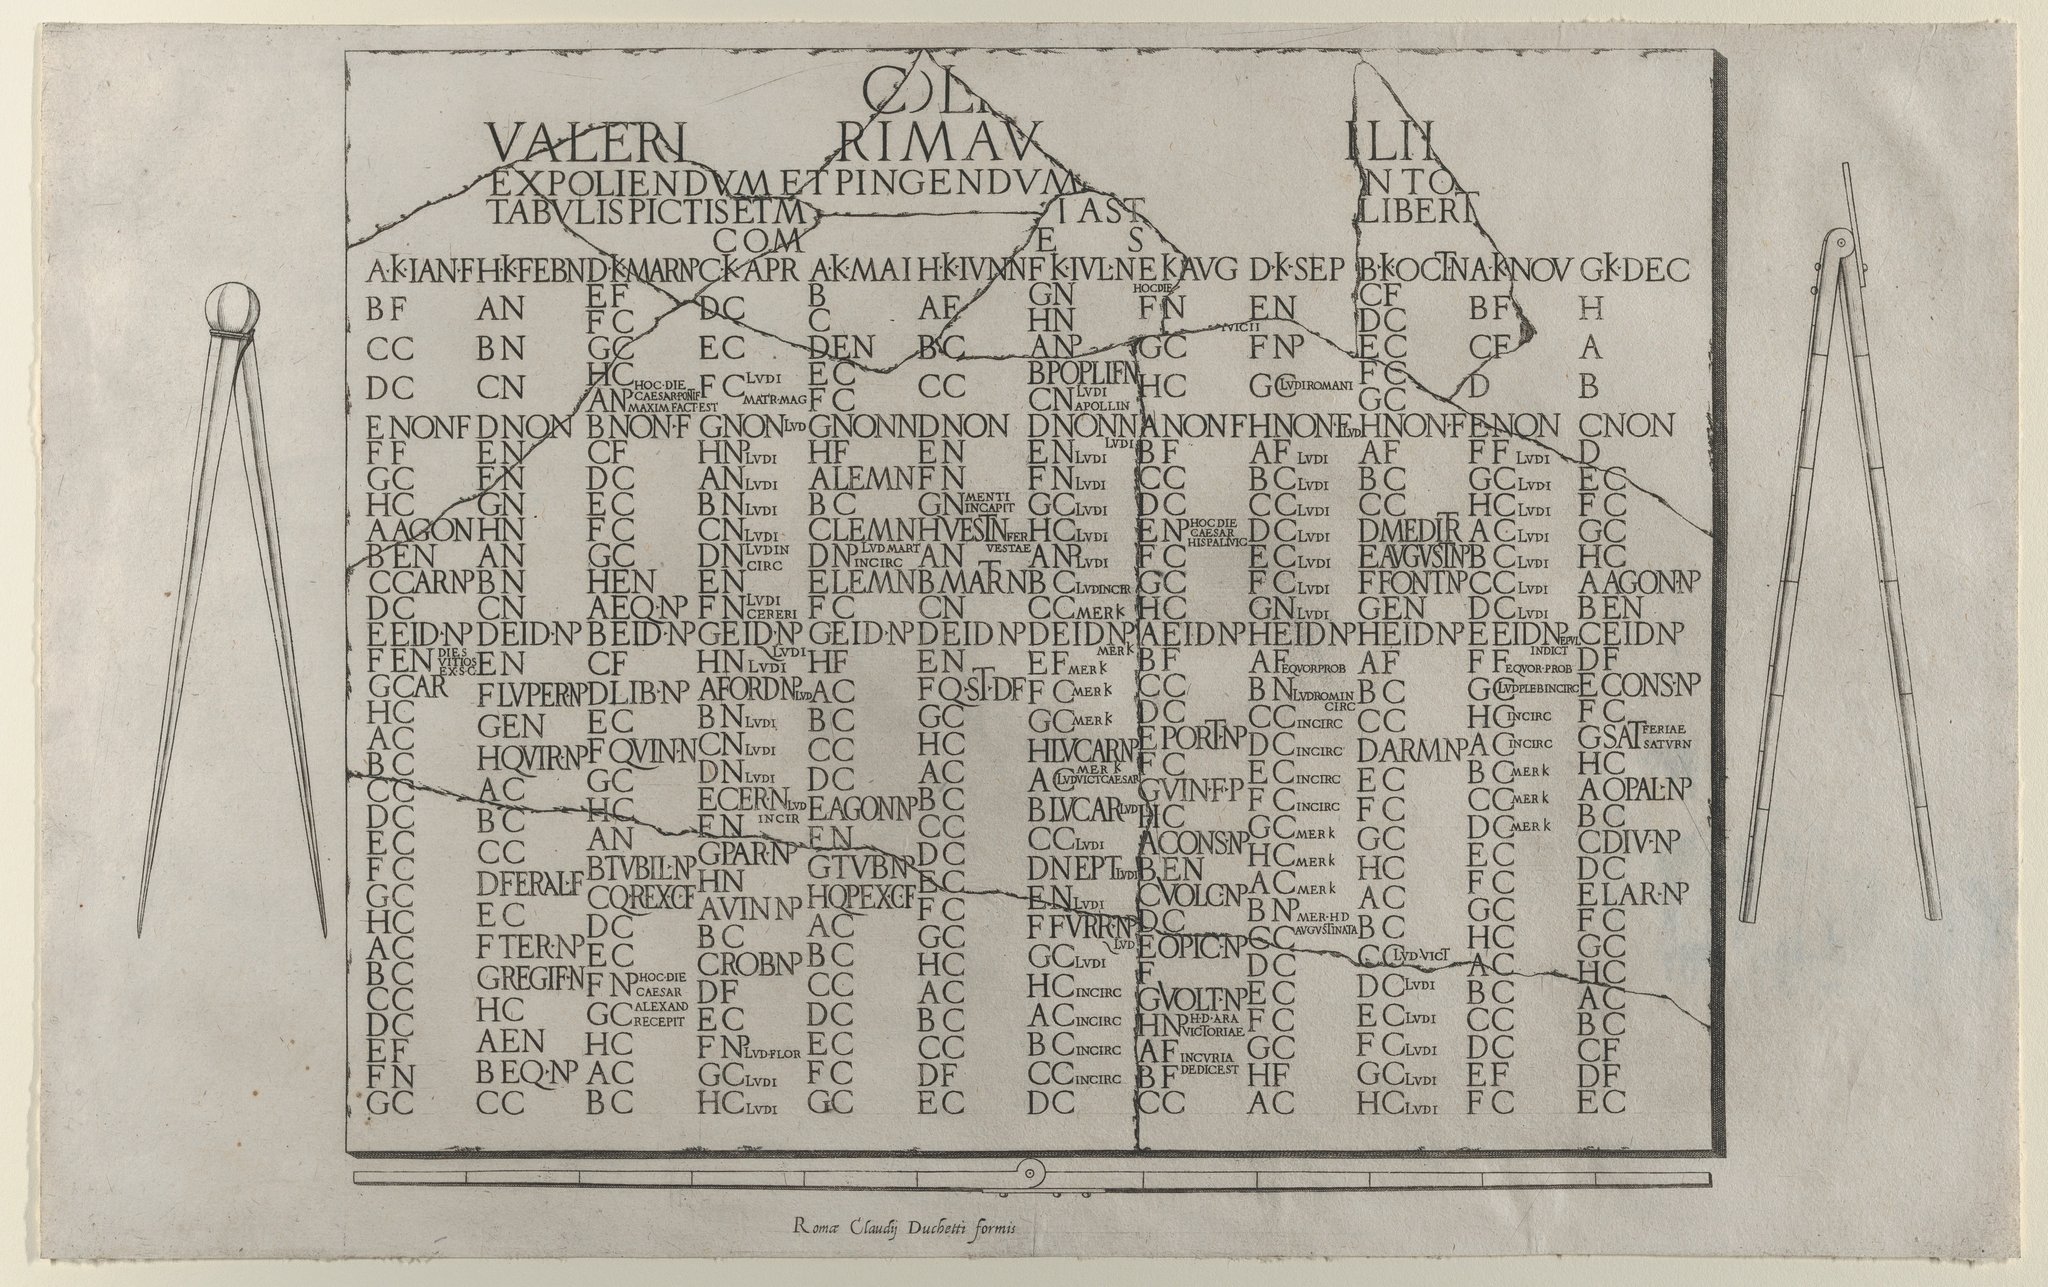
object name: print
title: Tablet with Calendar from the Farnese Palace, from "Speculum Romanae Magnificentiae"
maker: Anonymous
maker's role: artist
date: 1567-1600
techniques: engraving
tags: calendars